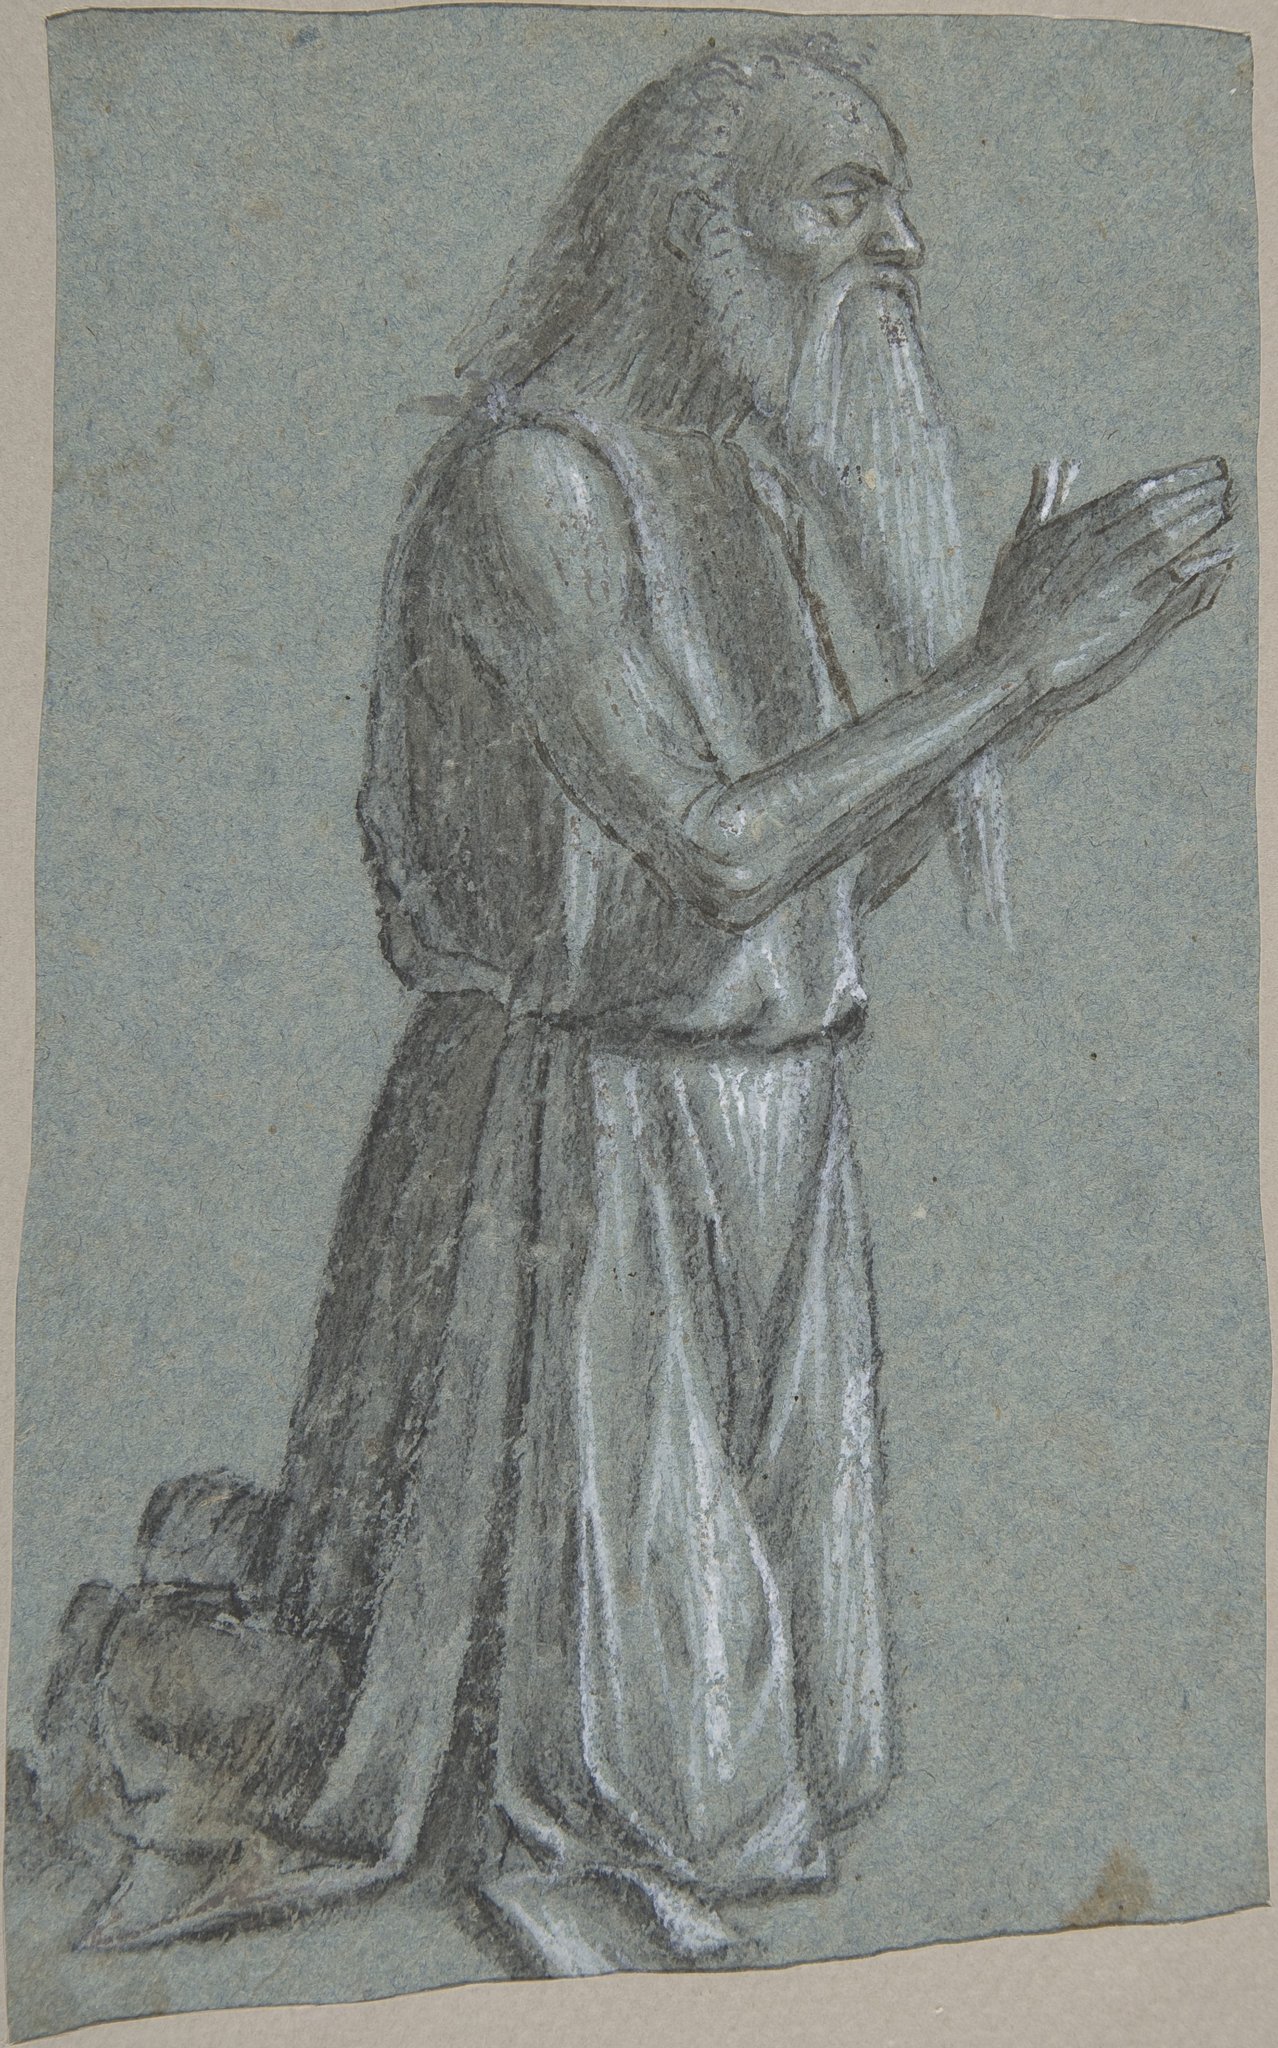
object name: drawing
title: Saint Jerome (recto); Soldier with a Spear (verso)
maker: vittore carpaccio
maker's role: artist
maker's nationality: italian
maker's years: 1460-1526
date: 1460-1525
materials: chalk, charcoal, gouache, ink, paper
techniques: brush, highlighting, wash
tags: soldiers,spears,saint jerome